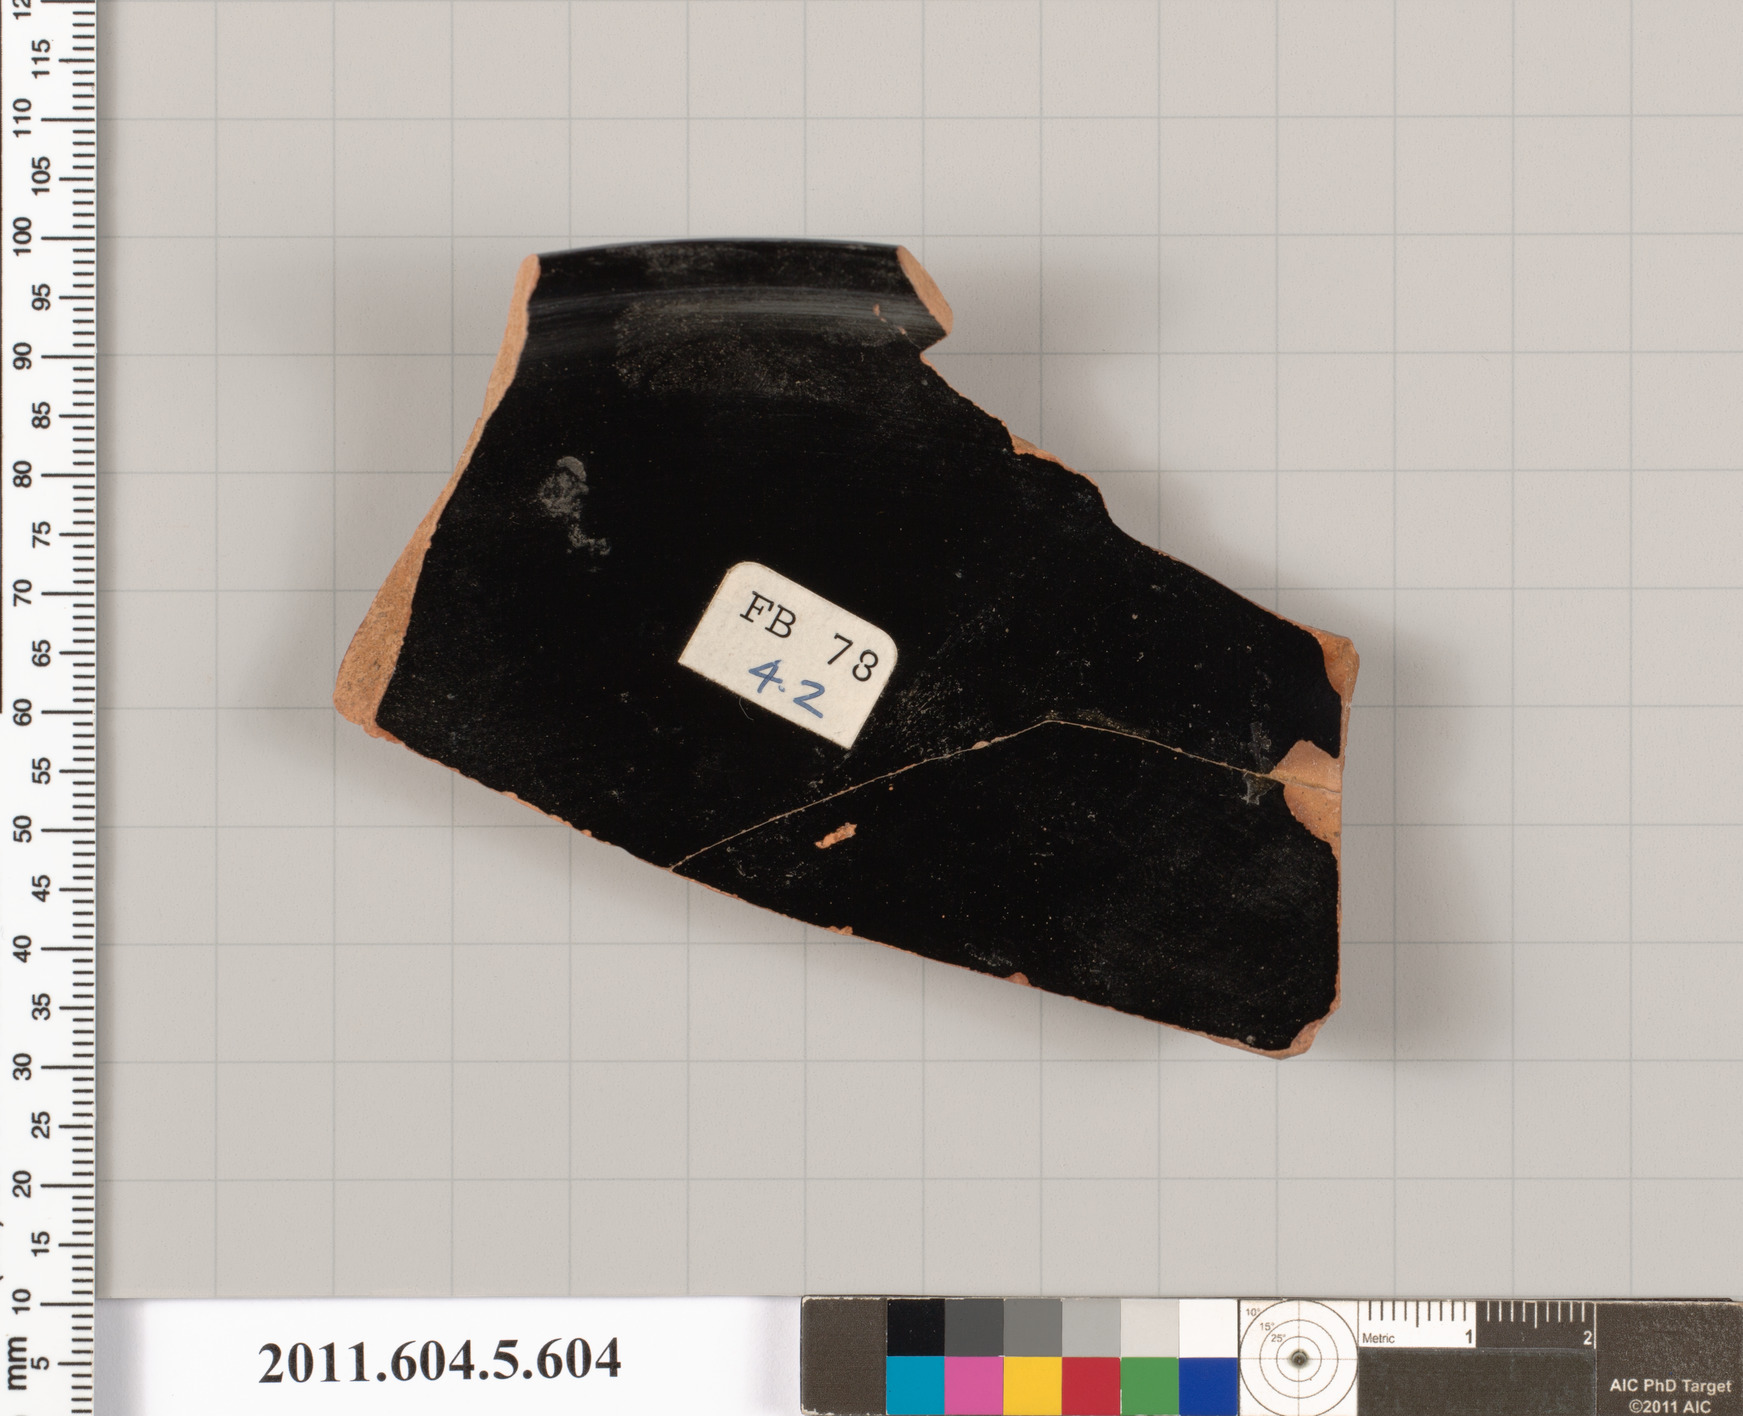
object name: kylix fragment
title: Terracotta rim fragment of a kylix (drinking cup)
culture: greek, attic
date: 600-401 BCE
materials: terracotta